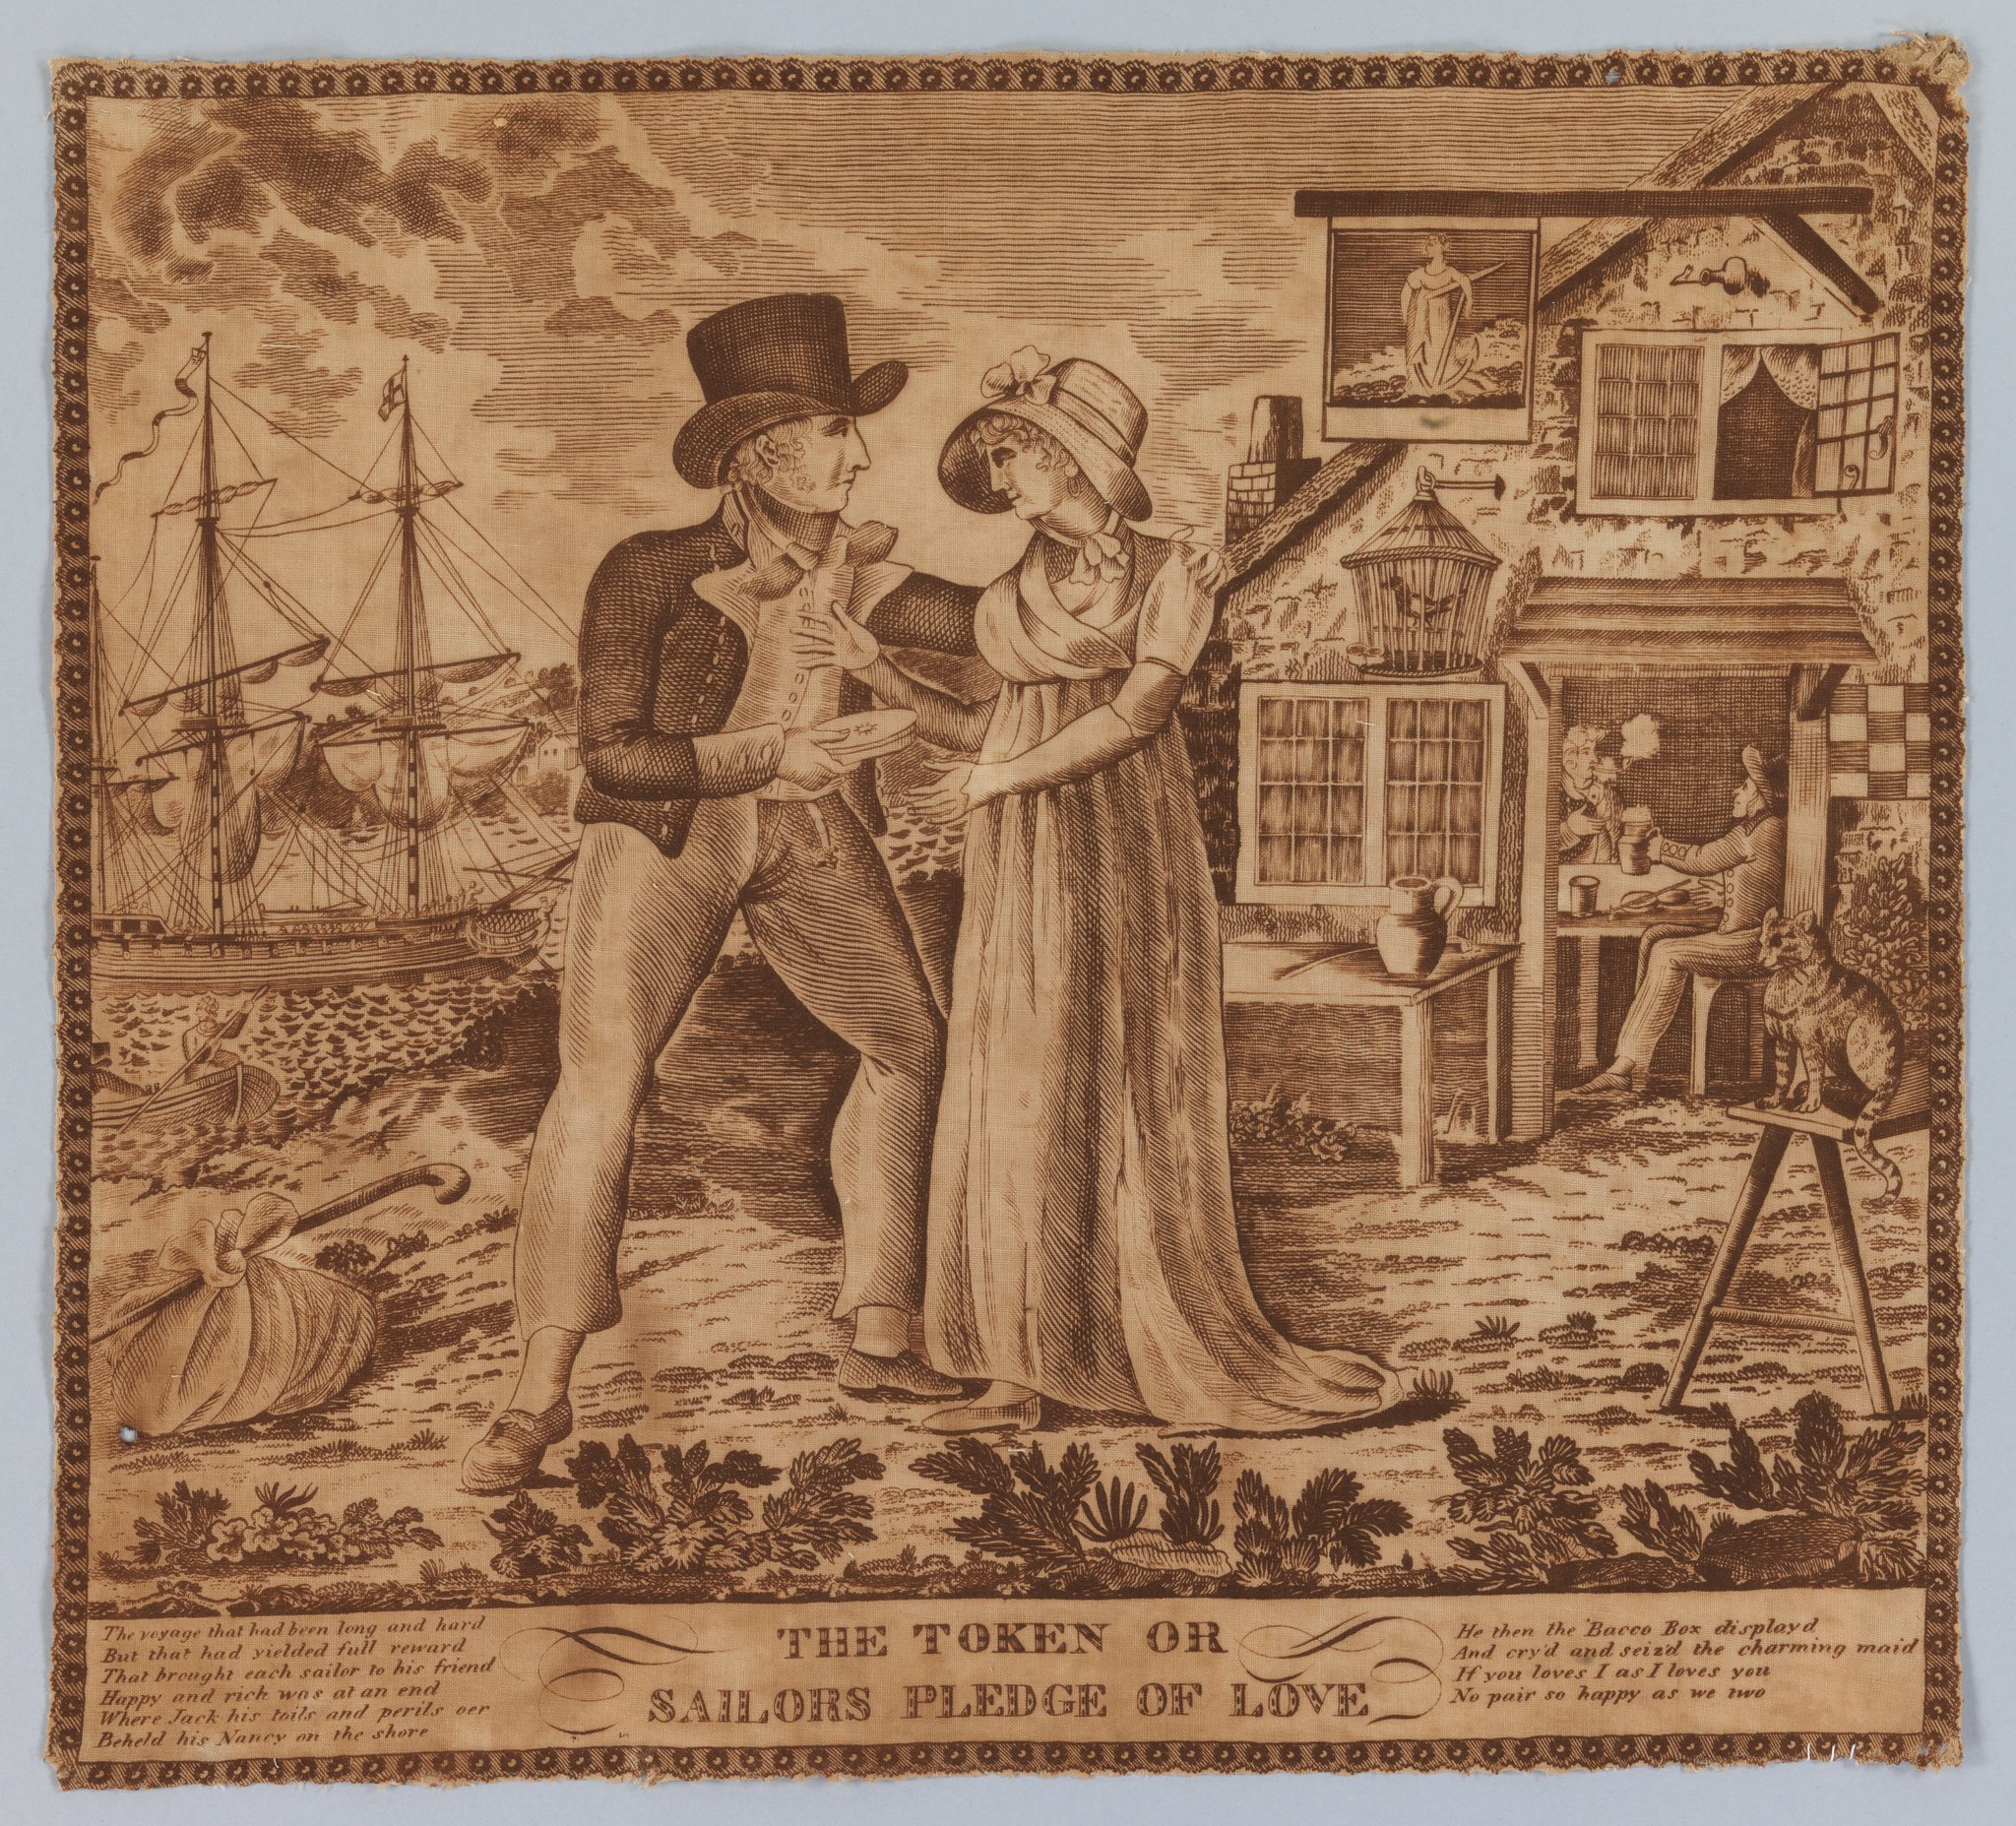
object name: handkerchief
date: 1767-1800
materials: cotton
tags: men,women,cats,ships